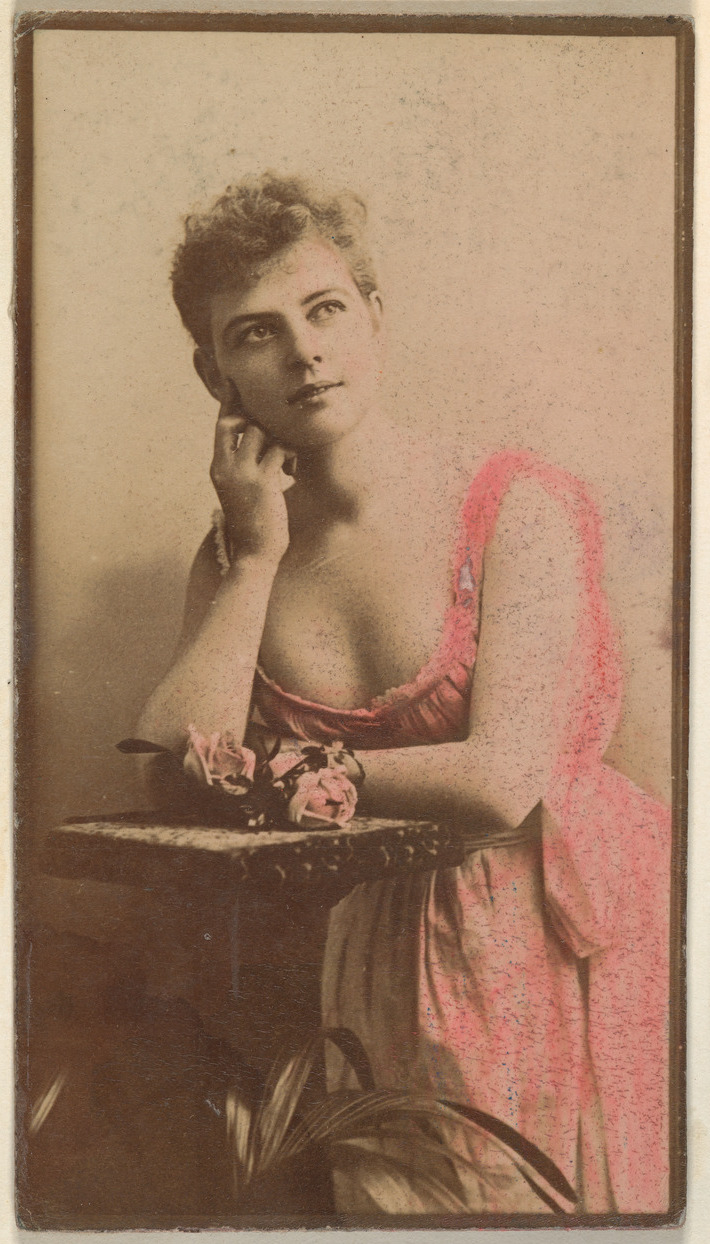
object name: photograph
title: Actress wearing hand-colored pink dress, from the Actresses series (N668)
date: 1888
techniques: albumen silver print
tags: portraits,women,actresses